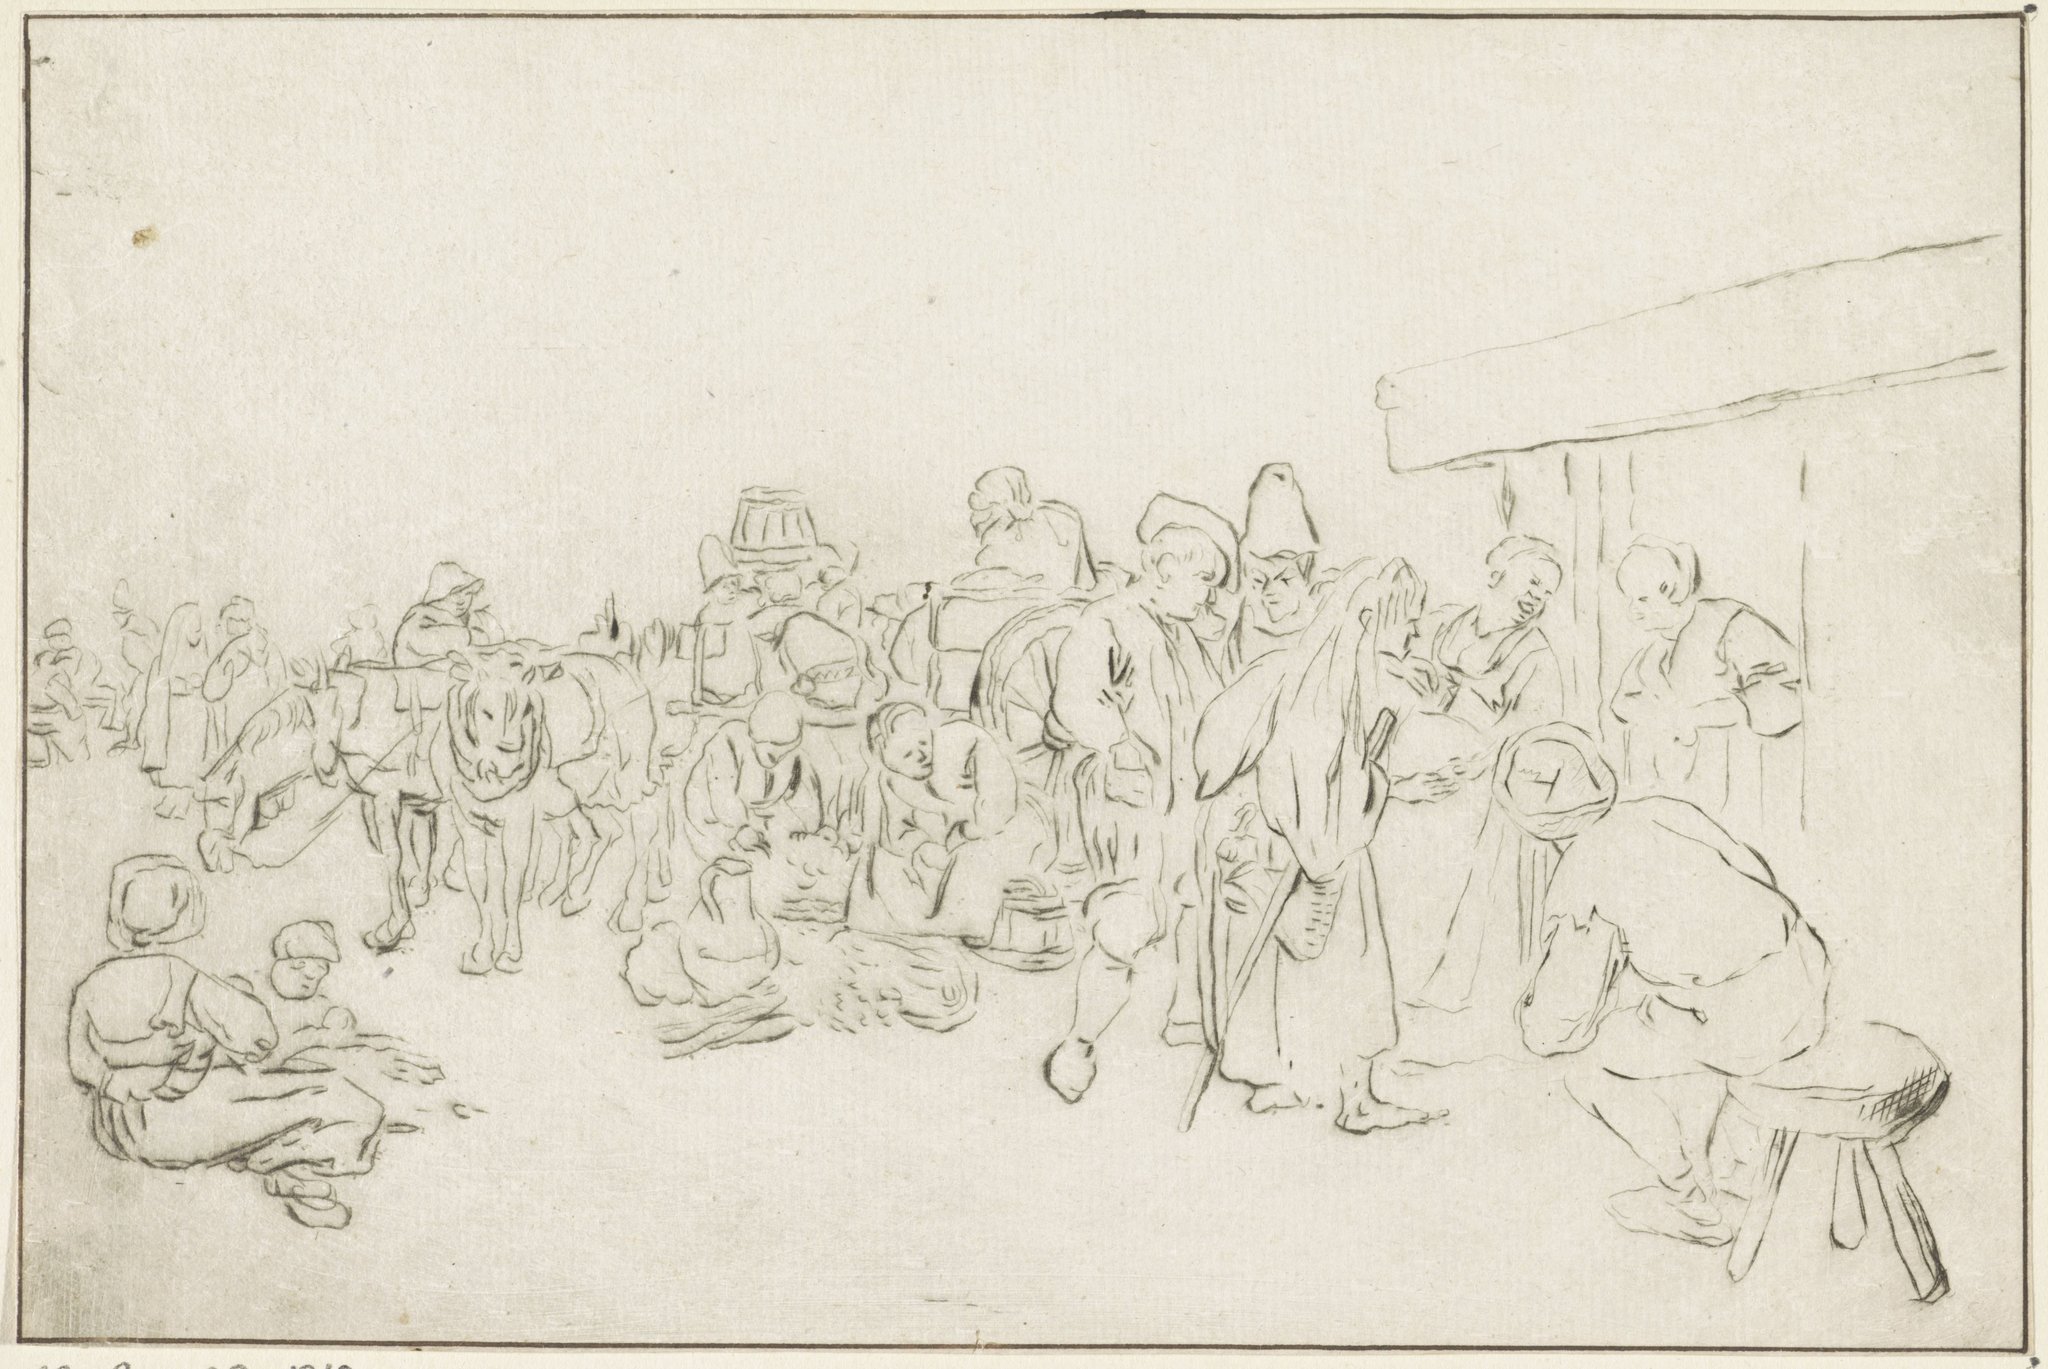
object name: print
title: Markt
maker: willem van wessem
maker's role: print maker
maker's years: 1725-1787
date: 1735-1787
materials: paper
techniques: etching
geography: amsterdam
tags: horse, market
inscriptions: collector's mark: Lugt 2228, collector's mark: Lugt 2760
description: Een mensenmenigte op een markt. Rechts een vrouw leunend op een onderdeur.